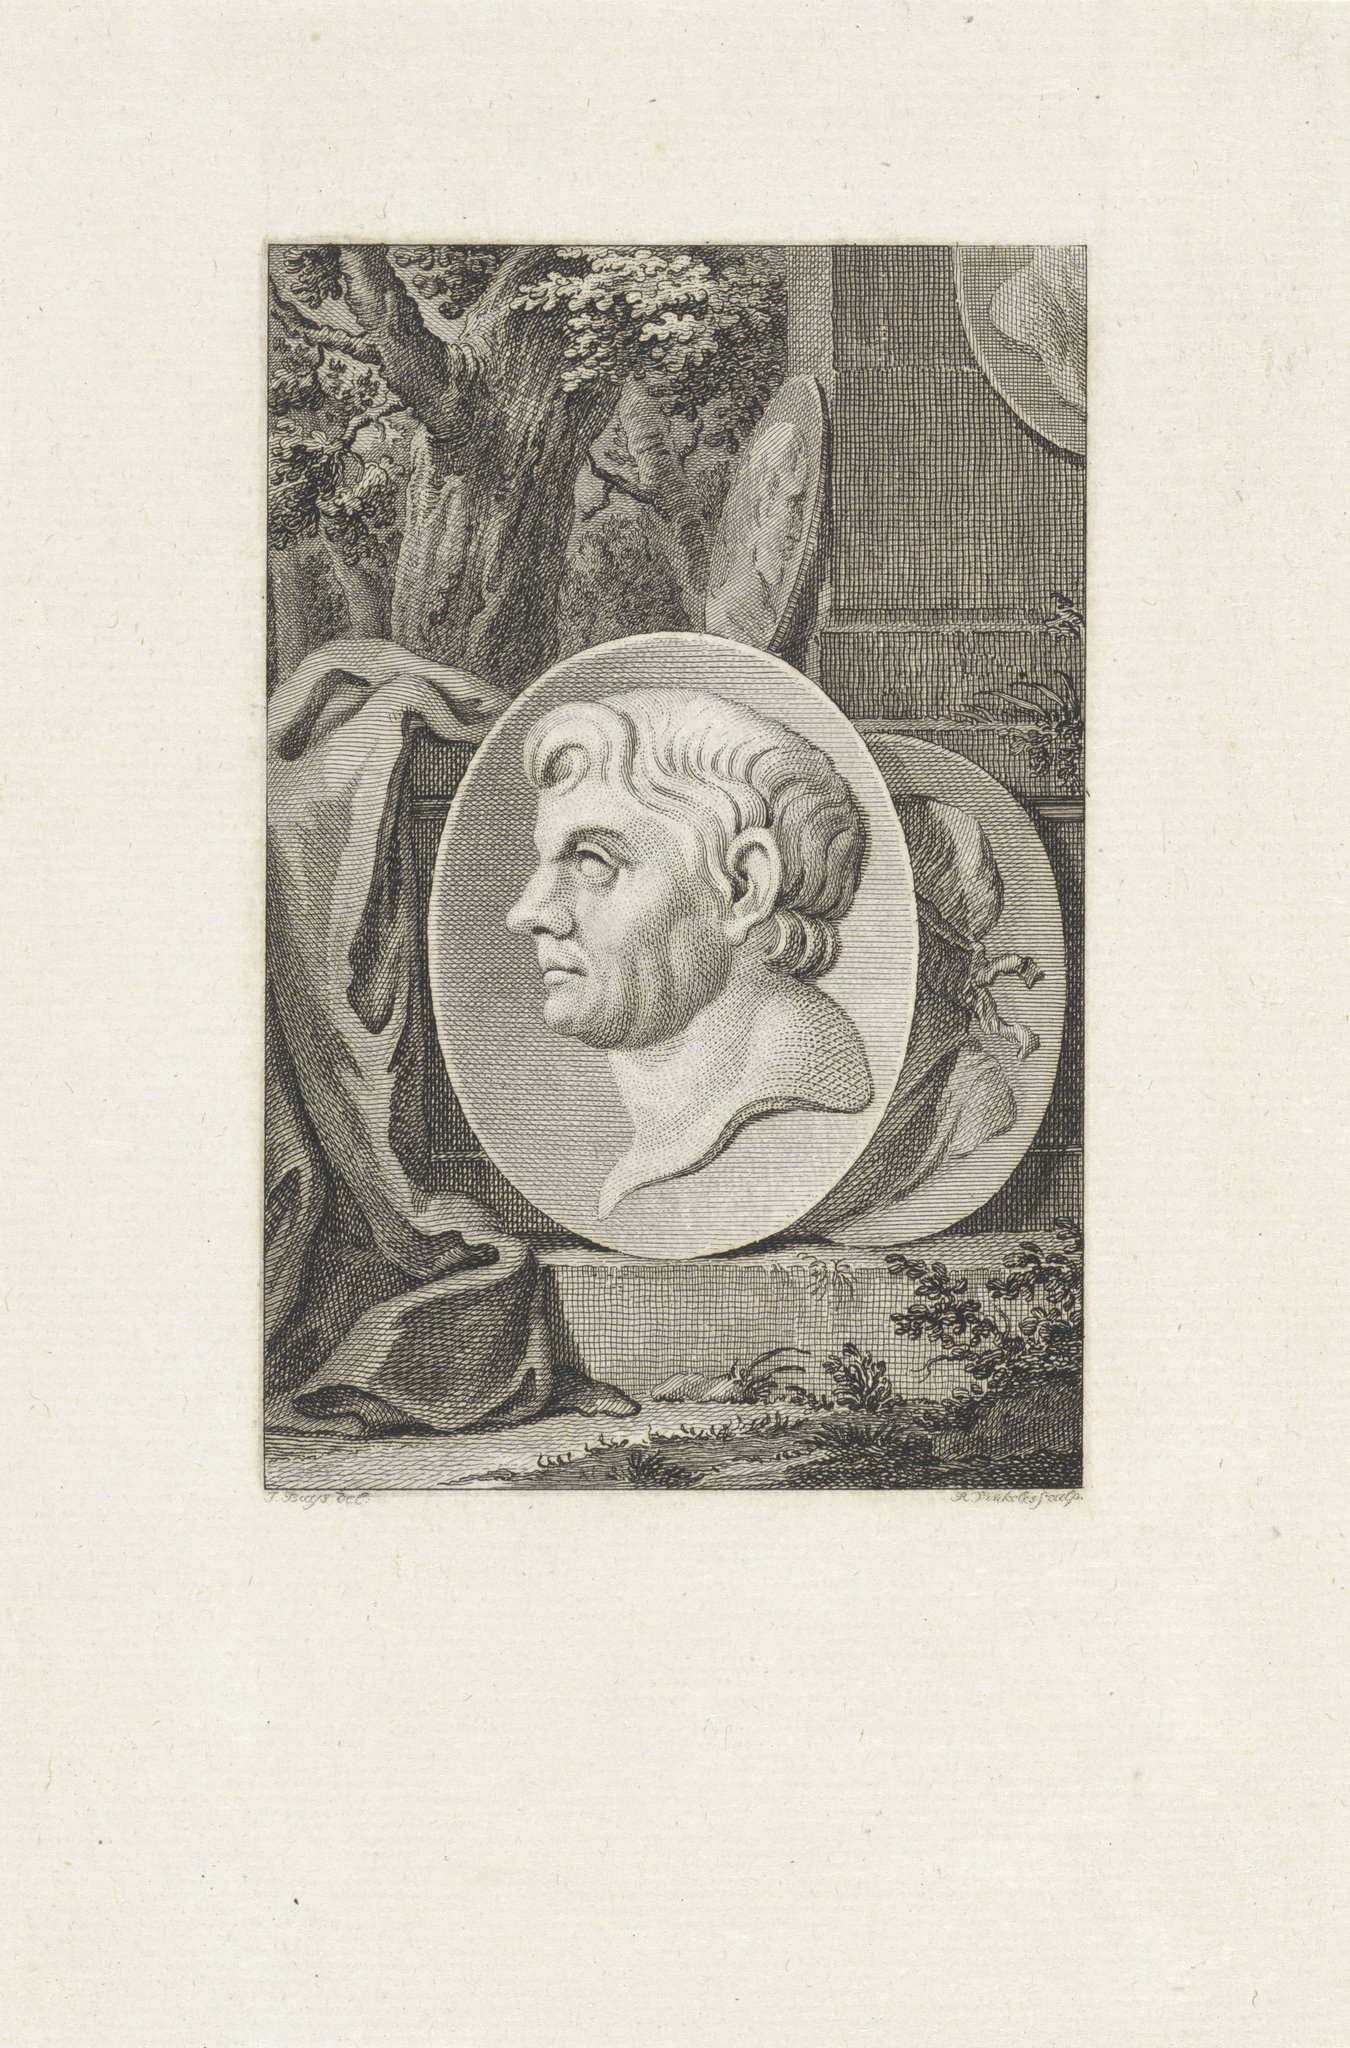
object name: print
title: Medaillon met het portret van Pompeius de Grote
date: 1789-1809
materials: paper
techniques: etching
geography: amsterdam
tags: (story of) gnaeus pompeius magnus, pompey the great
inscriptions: collector's mark: Lugt 240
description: Latere staat prent ook gebruikt als boekillustratie in: Plutarchus [bewerkt door E. Wassenbergh en H. Bosscha]. De levens van doorluchtige Grieken en Romeinen, onderling vergeleeken (...). 12 dln. Amsterdam: Johannes Allart, 1789-1809.